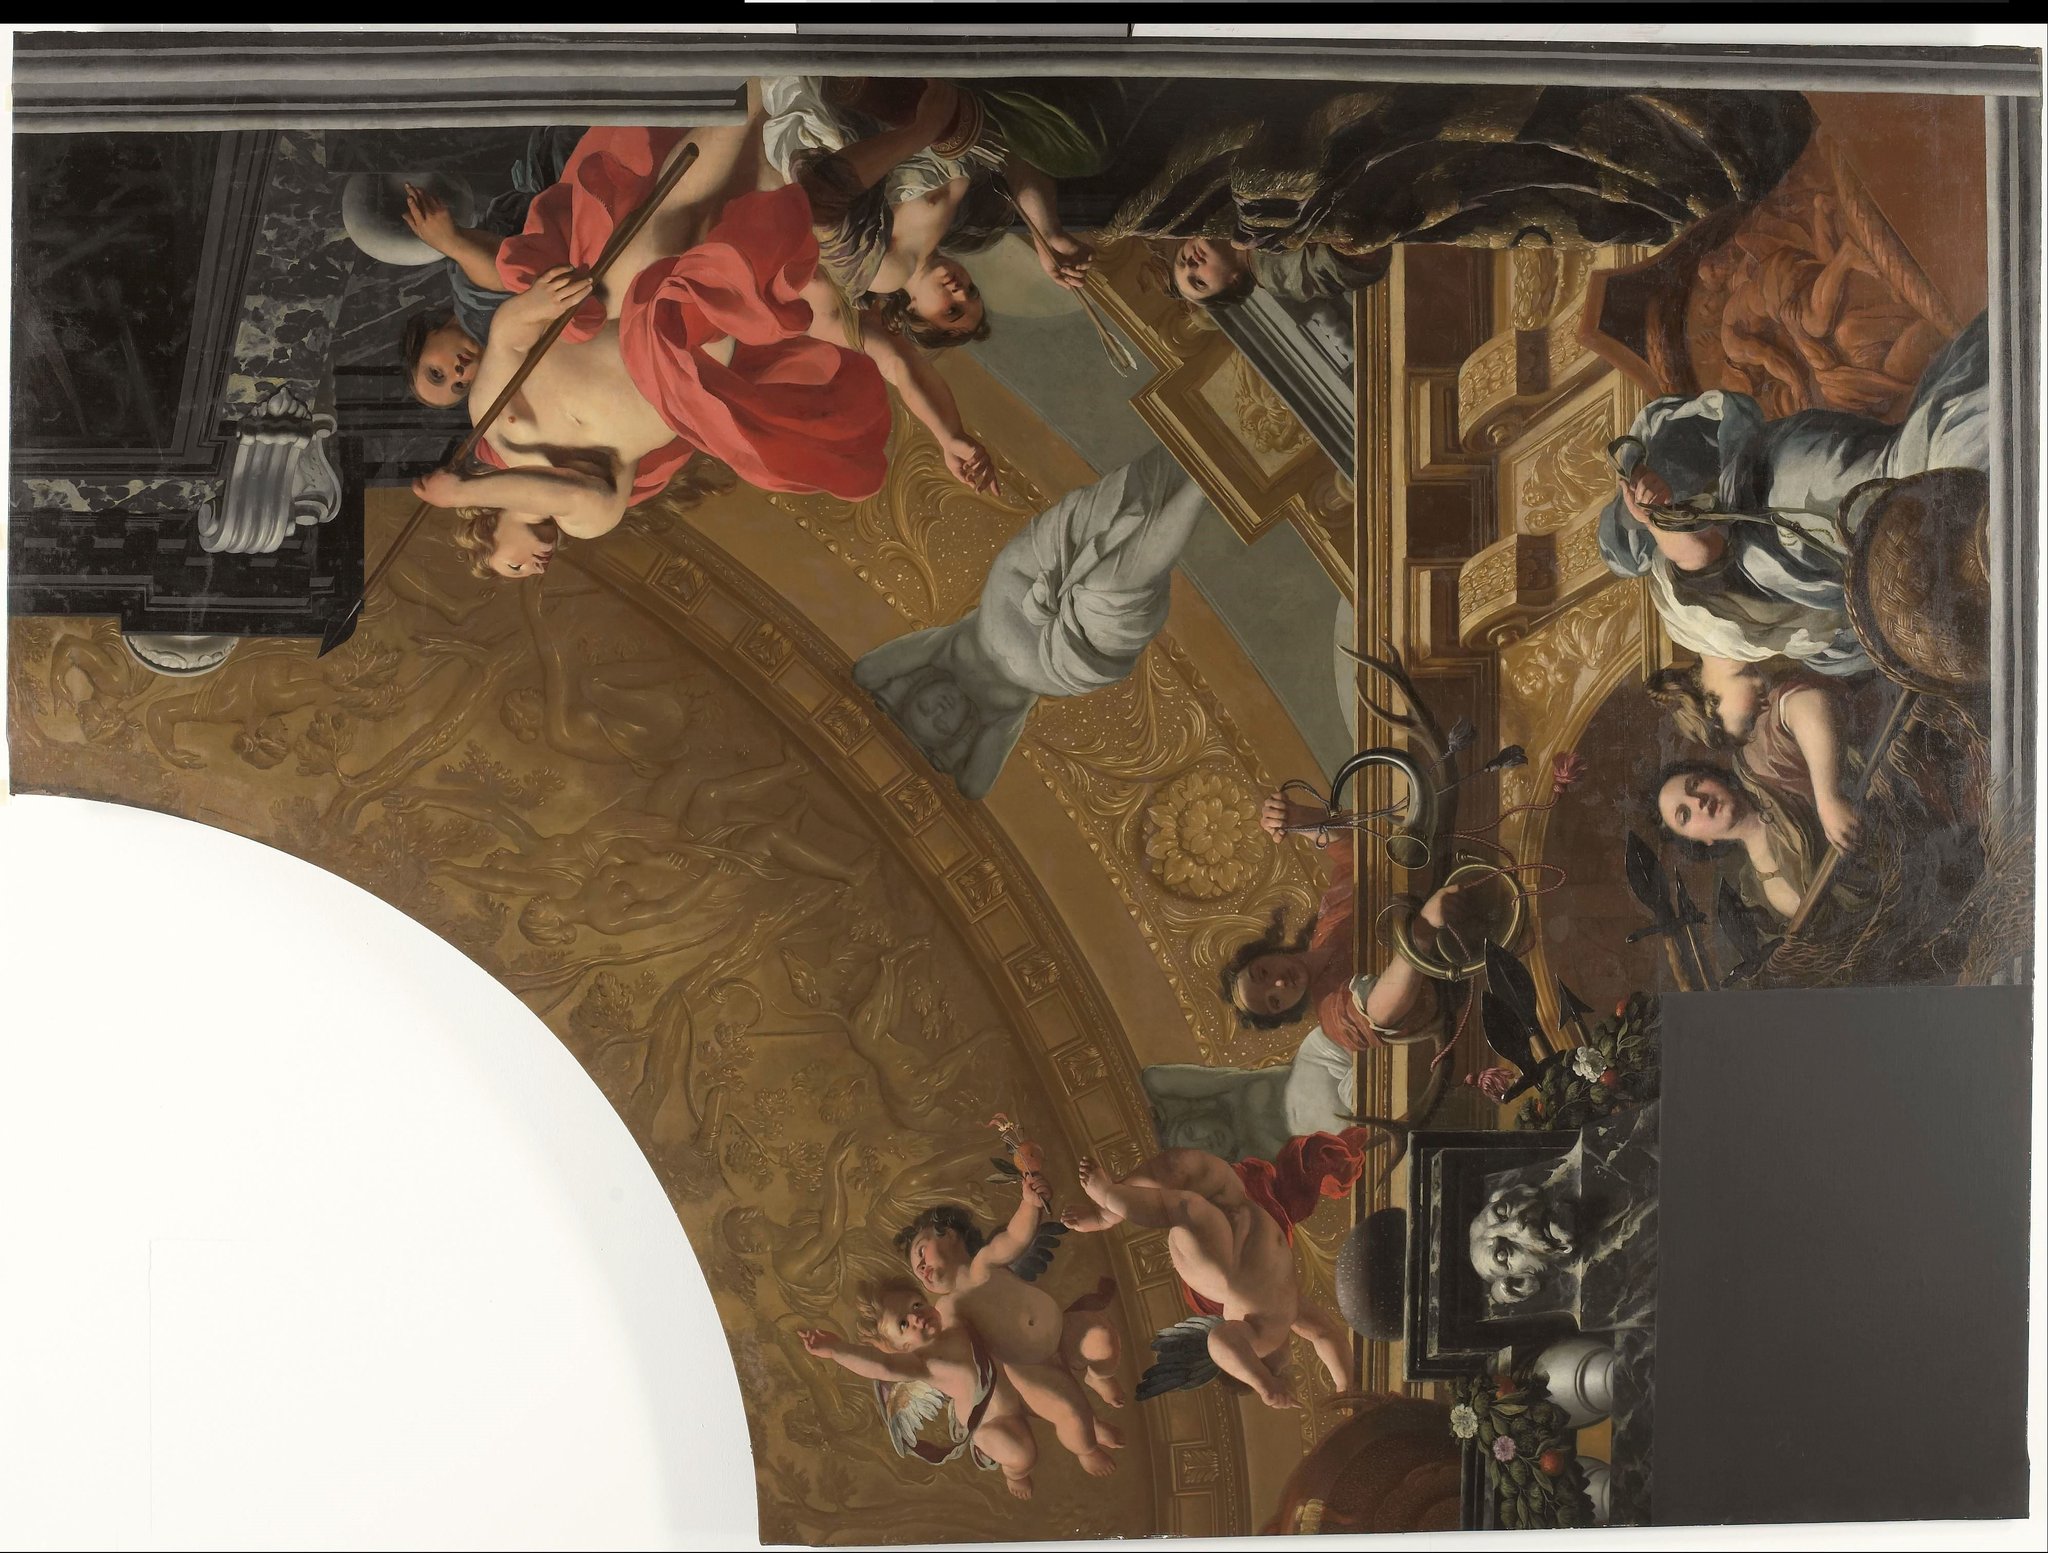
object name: painting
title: Part (top right) of a ceiling decoration with Diana and her companions as the principal representation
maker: gerard de lairesse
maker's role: draughtsman, painter, print maker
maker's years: 1641-1711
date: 1676-1682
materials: canvas, oil, paint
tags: (story of) diana (artemis)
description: Onderdeel (rechtsboven) van een plafondschildering van vijf delen met als hoofdvoorstelling Diana en haar gezellinnen, geschilderd voor de 'grote zaal' van Paleis Soestdijk.